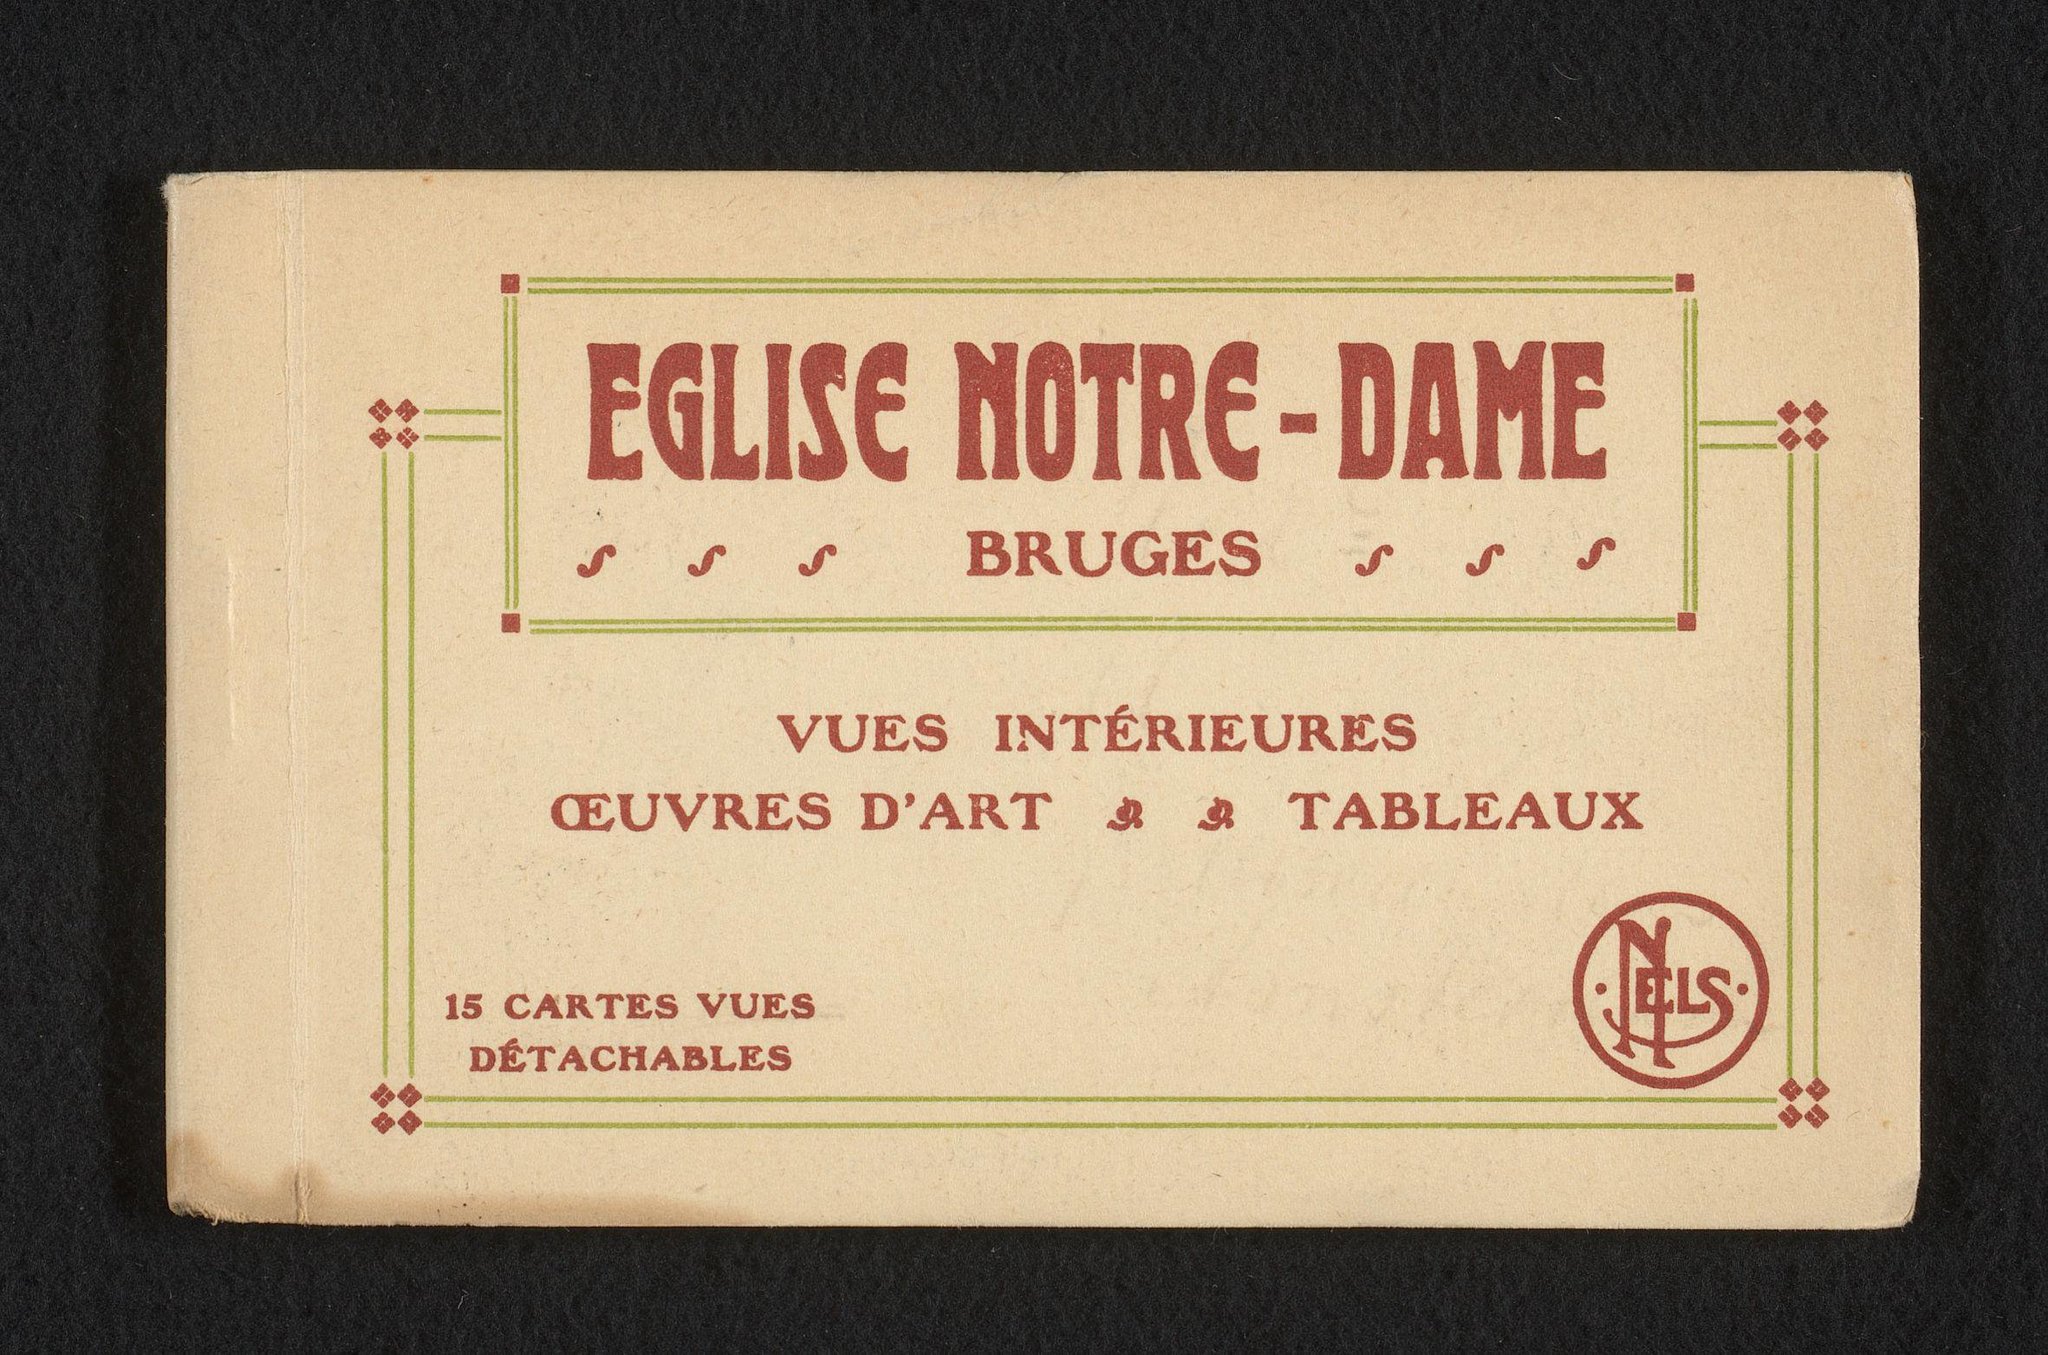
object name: album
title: Album met voorstellingen van de Onze-Lieve-Vrouwekerk in Brugge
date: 1913-1930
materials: cardboard, paper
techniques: photograph, printing block, stapling, writing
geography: brussels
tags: church (exterior), interior of church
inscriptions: postage stamp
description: Album met 1 losse en 14 uitscheurbare prentbriefkaarten van de Onze-Lieve-Vrouwekerk in Brugge. De losse prentbriefkaart is beschreven en verstuurd. De andere 14 kaarten zitten nog vast.